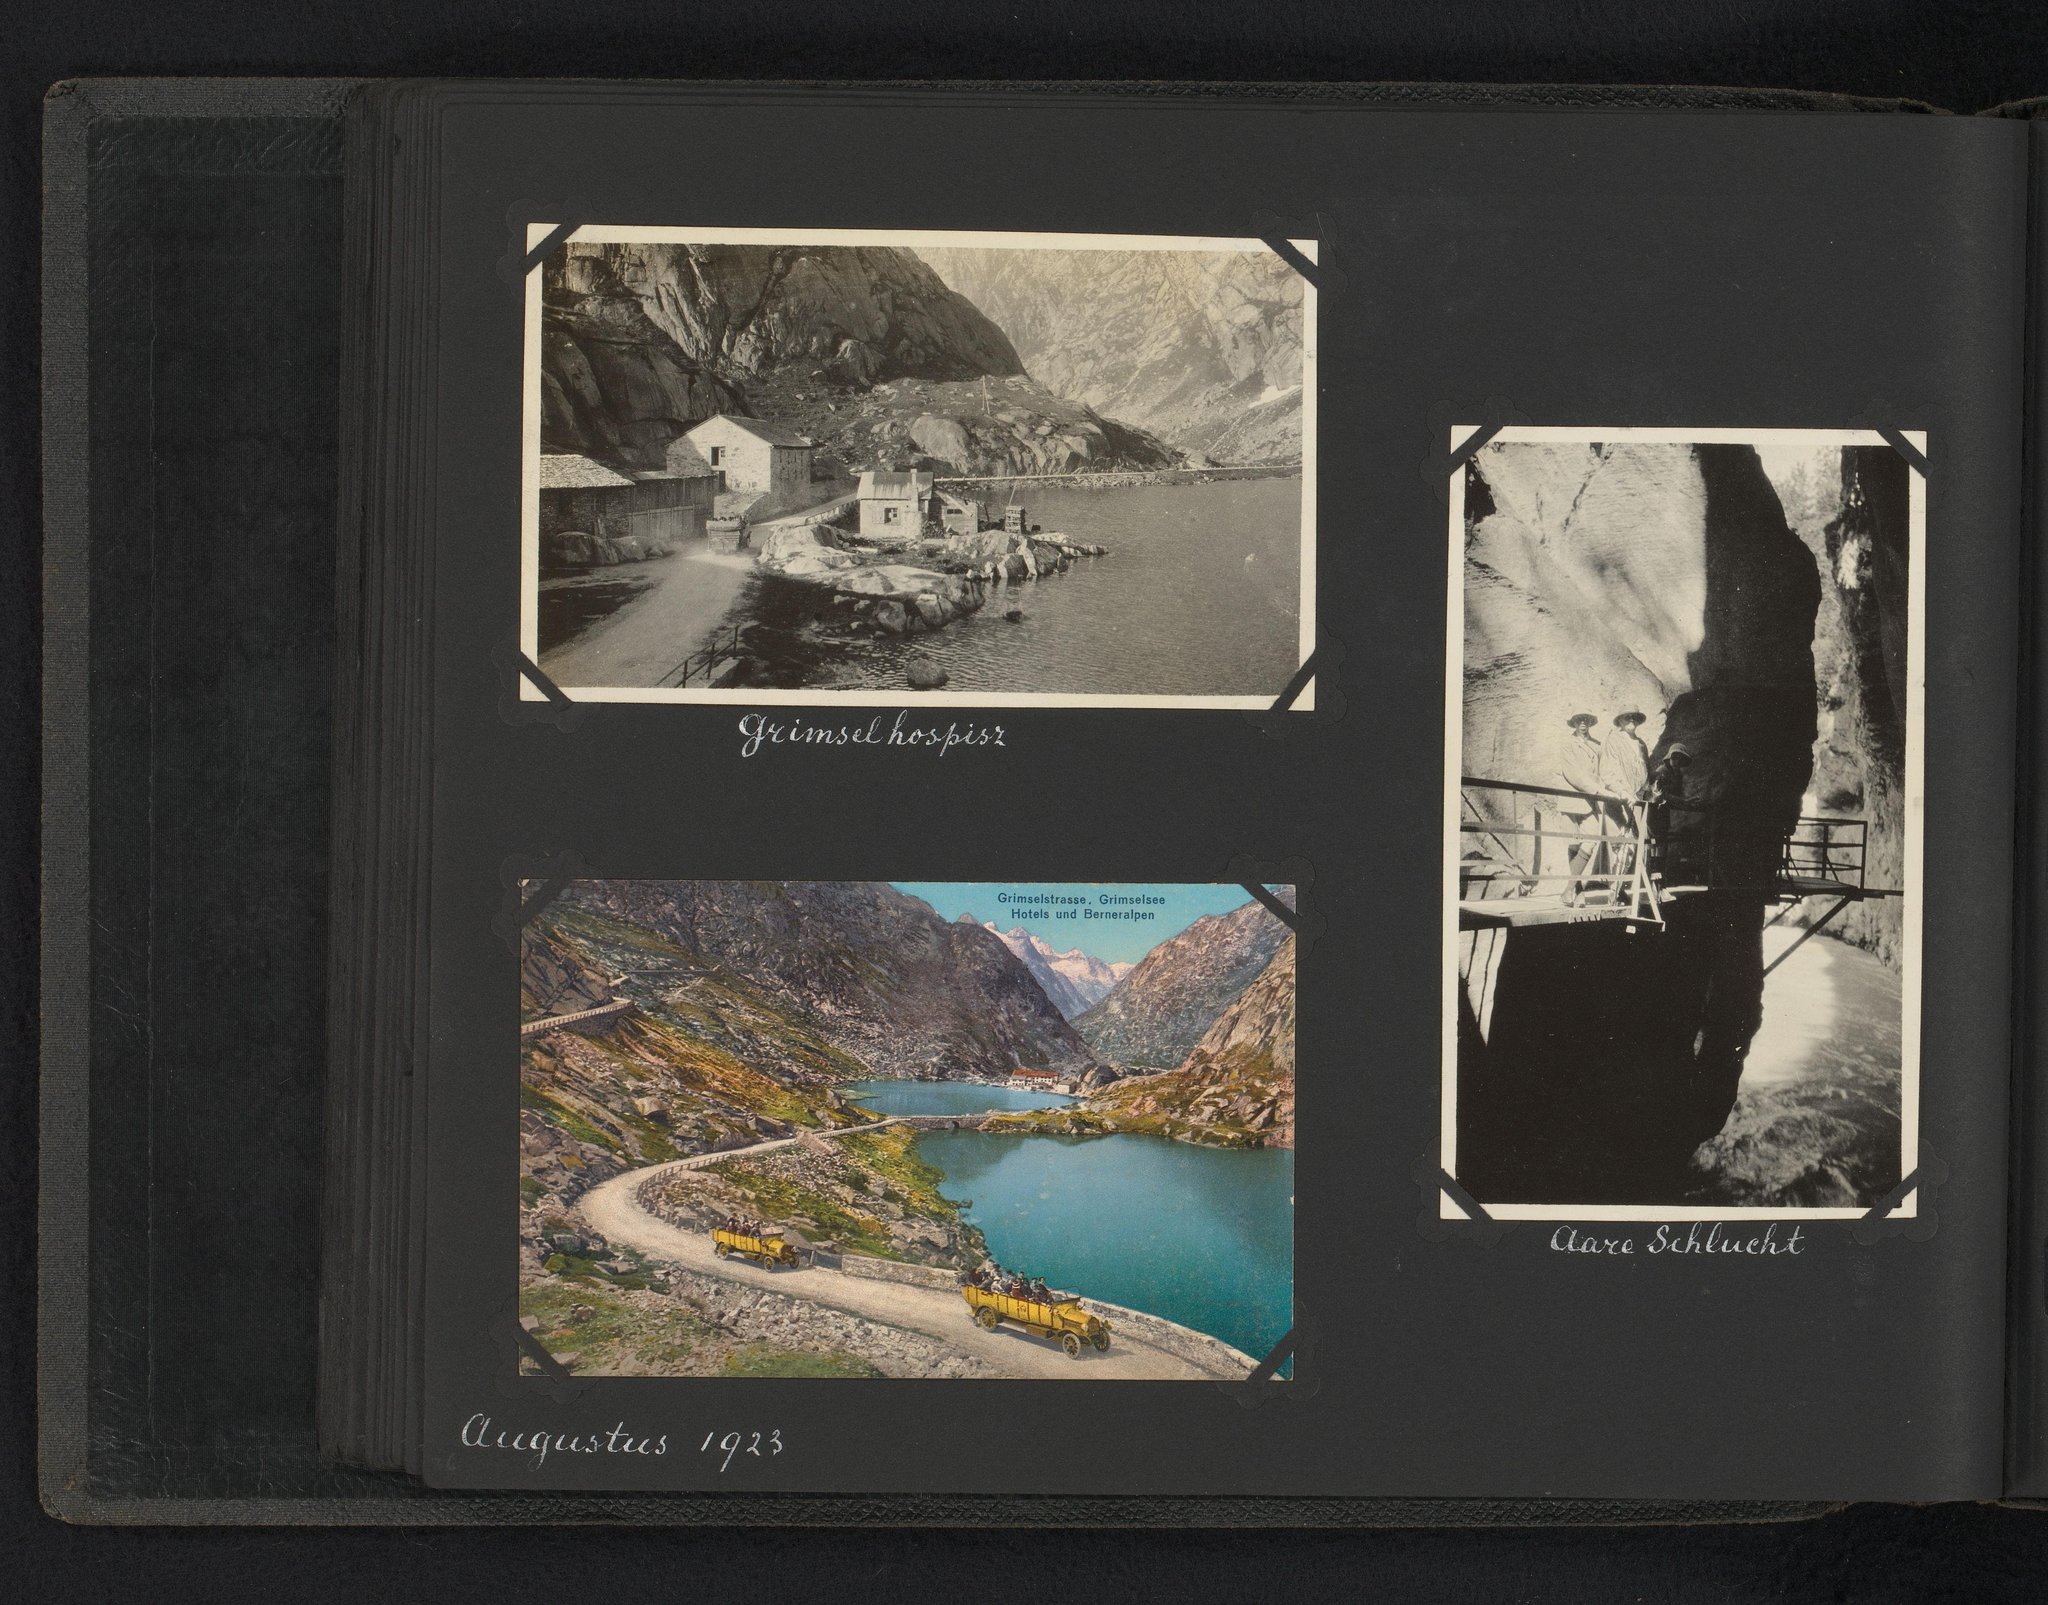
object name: photomechanical print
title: Augustus 1923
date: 1908-1923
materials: paper, cardboard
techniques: gelatin silver print, photolithography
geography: bern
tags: the hague, caroline louise van den berg-van den berg, carel frederik van den berg (cay), amsterdam, frank willem van den berg (1912-1998), the family travelling, on holiday, lake, mountains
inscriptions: inscription: ‘Aare Schlucht’, inscription: ‘Grimselhospisz’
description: Deze foto's en prent maken deel uit van een album.